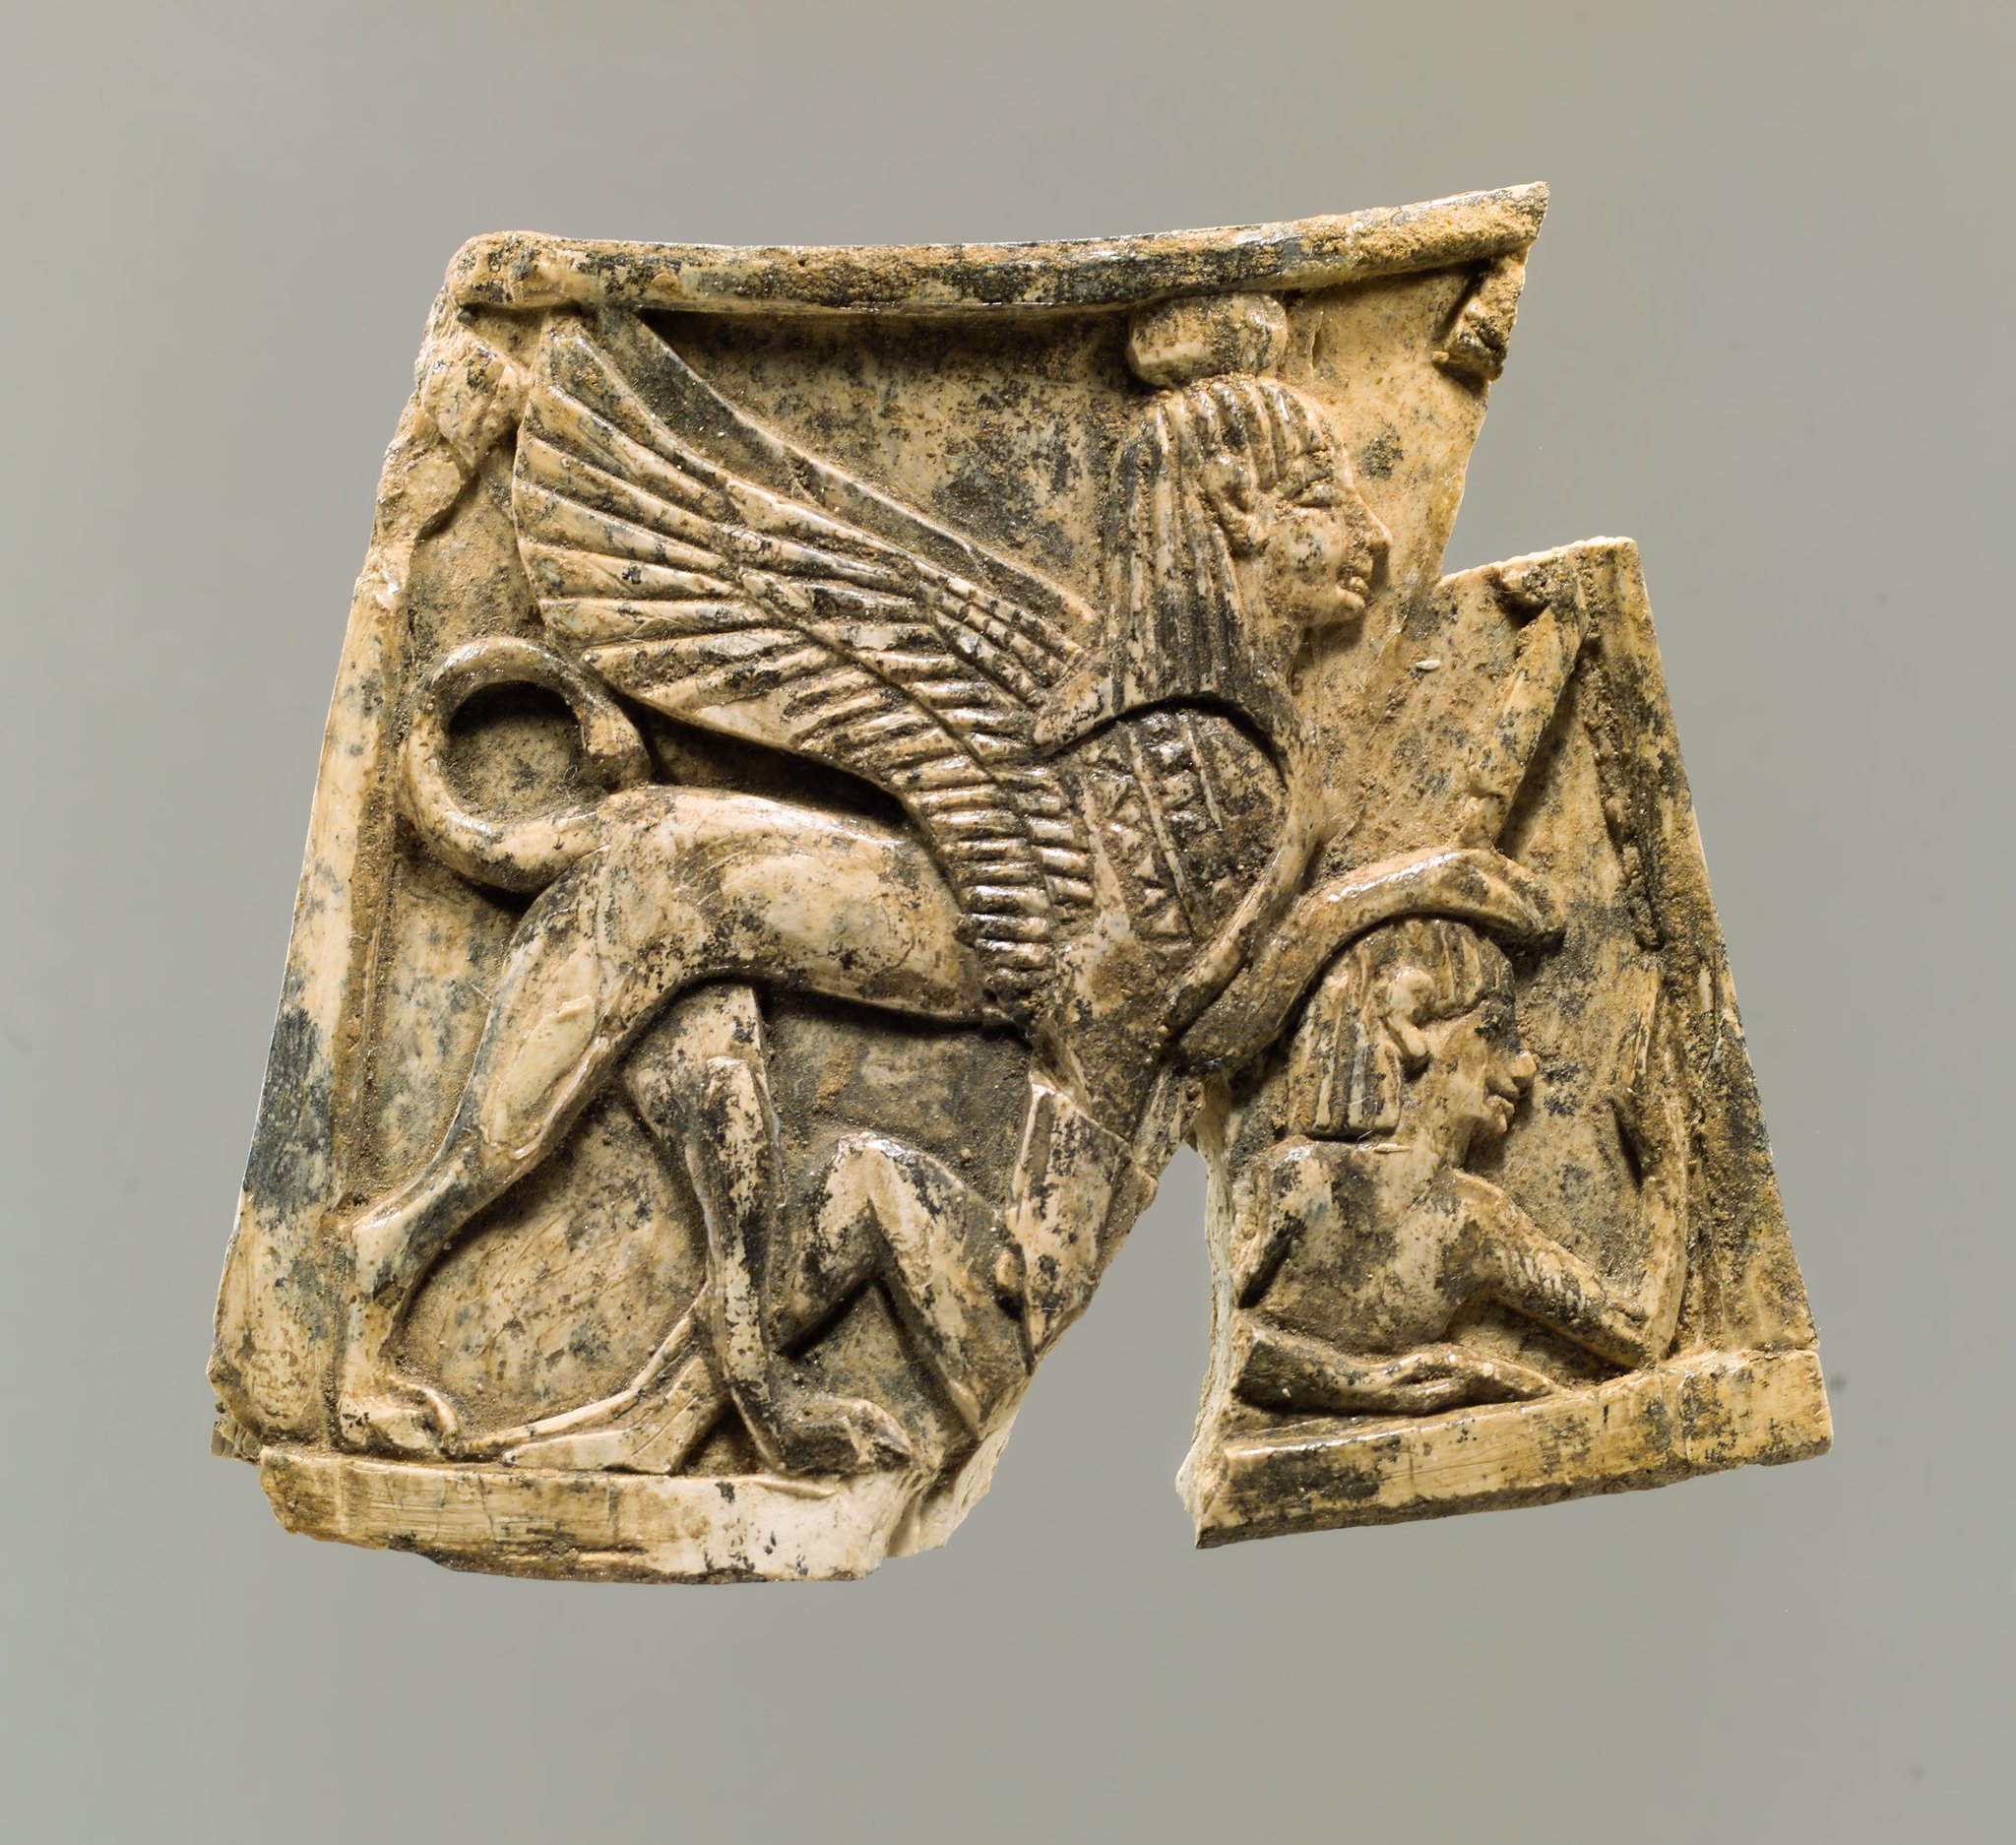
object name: relief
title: Plaque carved in relief with sphinx trampling figure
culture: assyrian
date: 800-601 BCE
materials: ivory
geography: mesopotamia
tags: men,sphinx